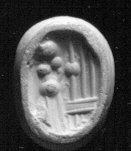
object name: stamp seal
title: Stamp seal (octagonal pyramid) with cultic scene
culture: assyro-babylonian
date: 700-501 BCE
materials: stone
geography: mesopotamia